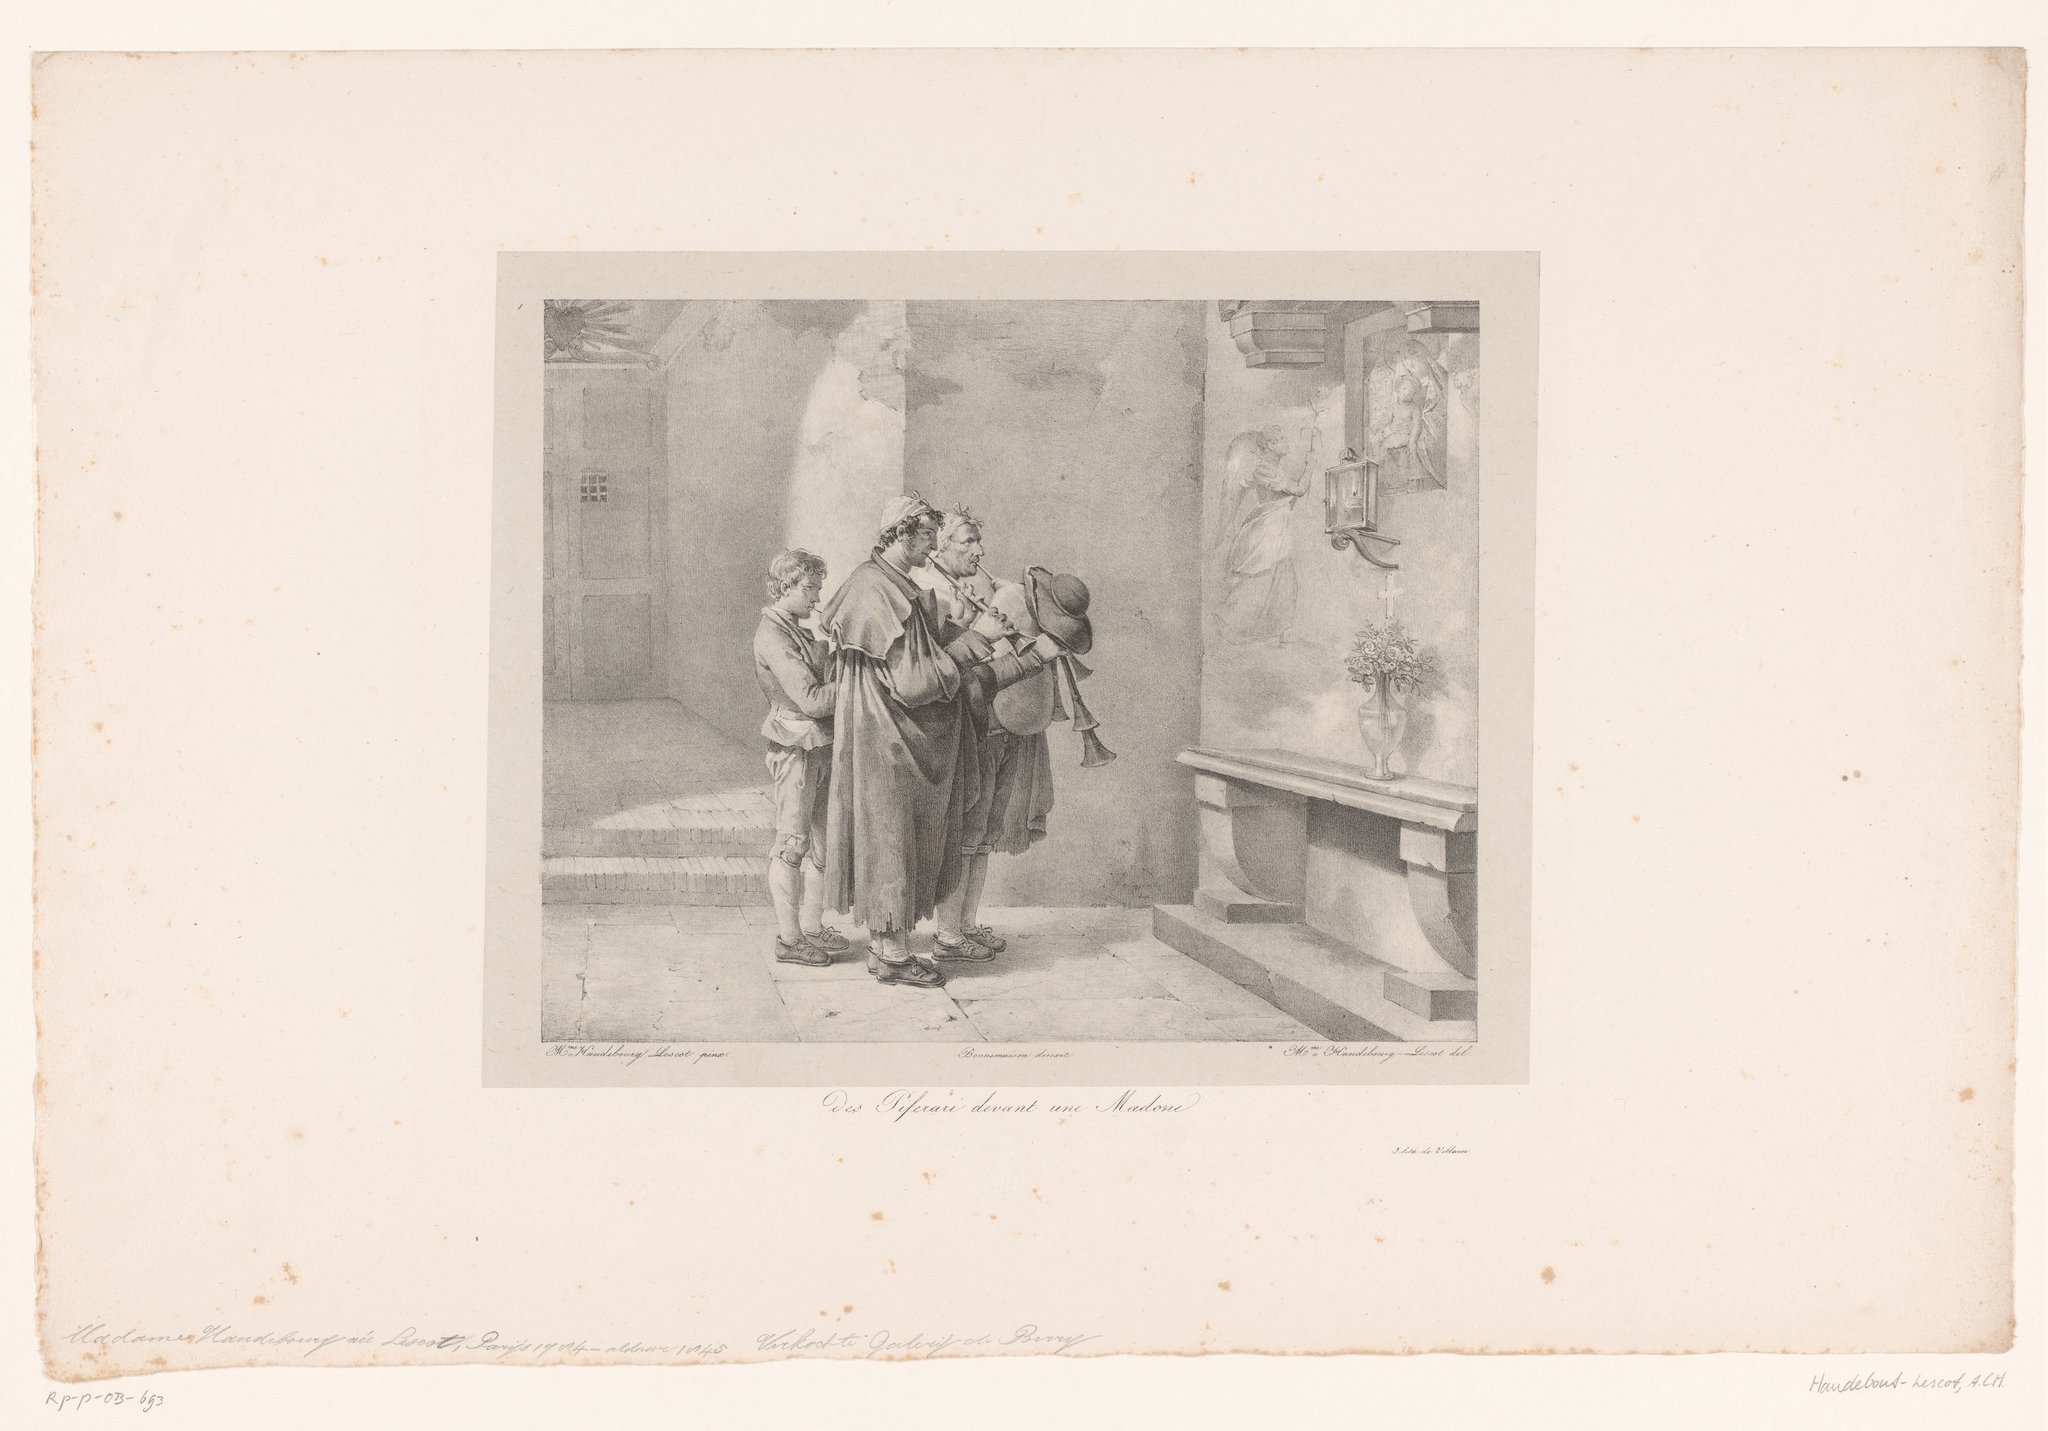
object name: print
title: Herders in een kapel spelen schalmei voor Maria met Kind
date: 1822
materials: paper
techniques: lithograph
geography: paris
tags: herding, herdsman, herdswoman, shepherd, shepherdess, cowherd, etc., clarinet, bassoon, oboe, shawm, playing instruments (in church), parts of church interior: chapel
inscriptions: check stamp: Lugt 4729